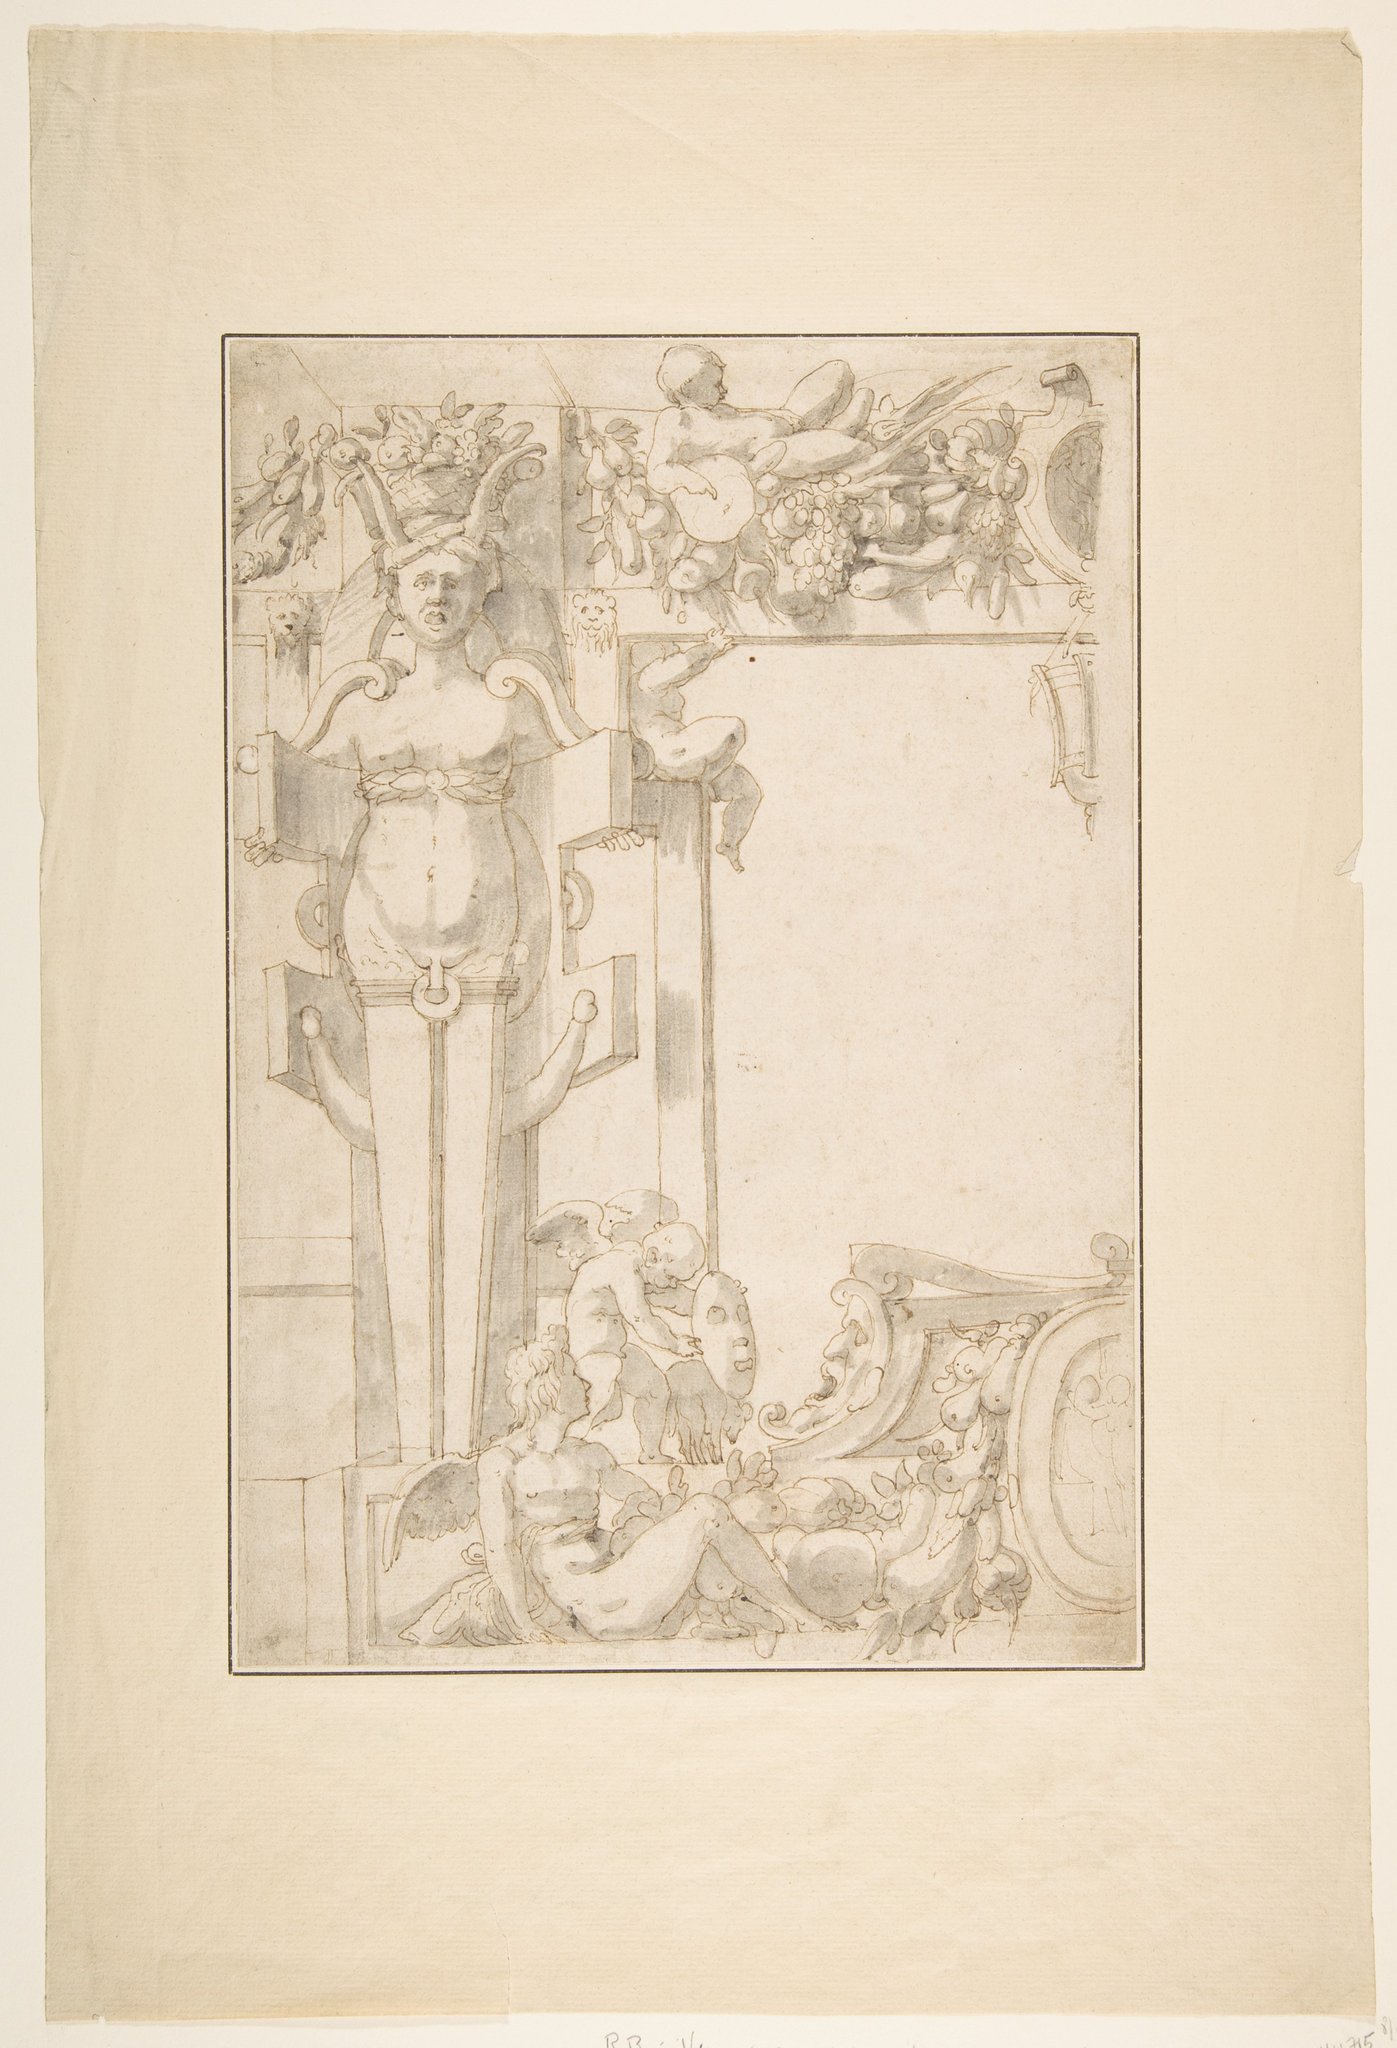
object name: ornament architecture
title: Design for a Wall Decoration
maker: rosso fiorentino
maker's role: artist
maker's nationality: italian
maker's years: 1494-1540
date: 1501-1600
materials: ink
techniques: brush, pen, wash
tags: male nudes,female nudes